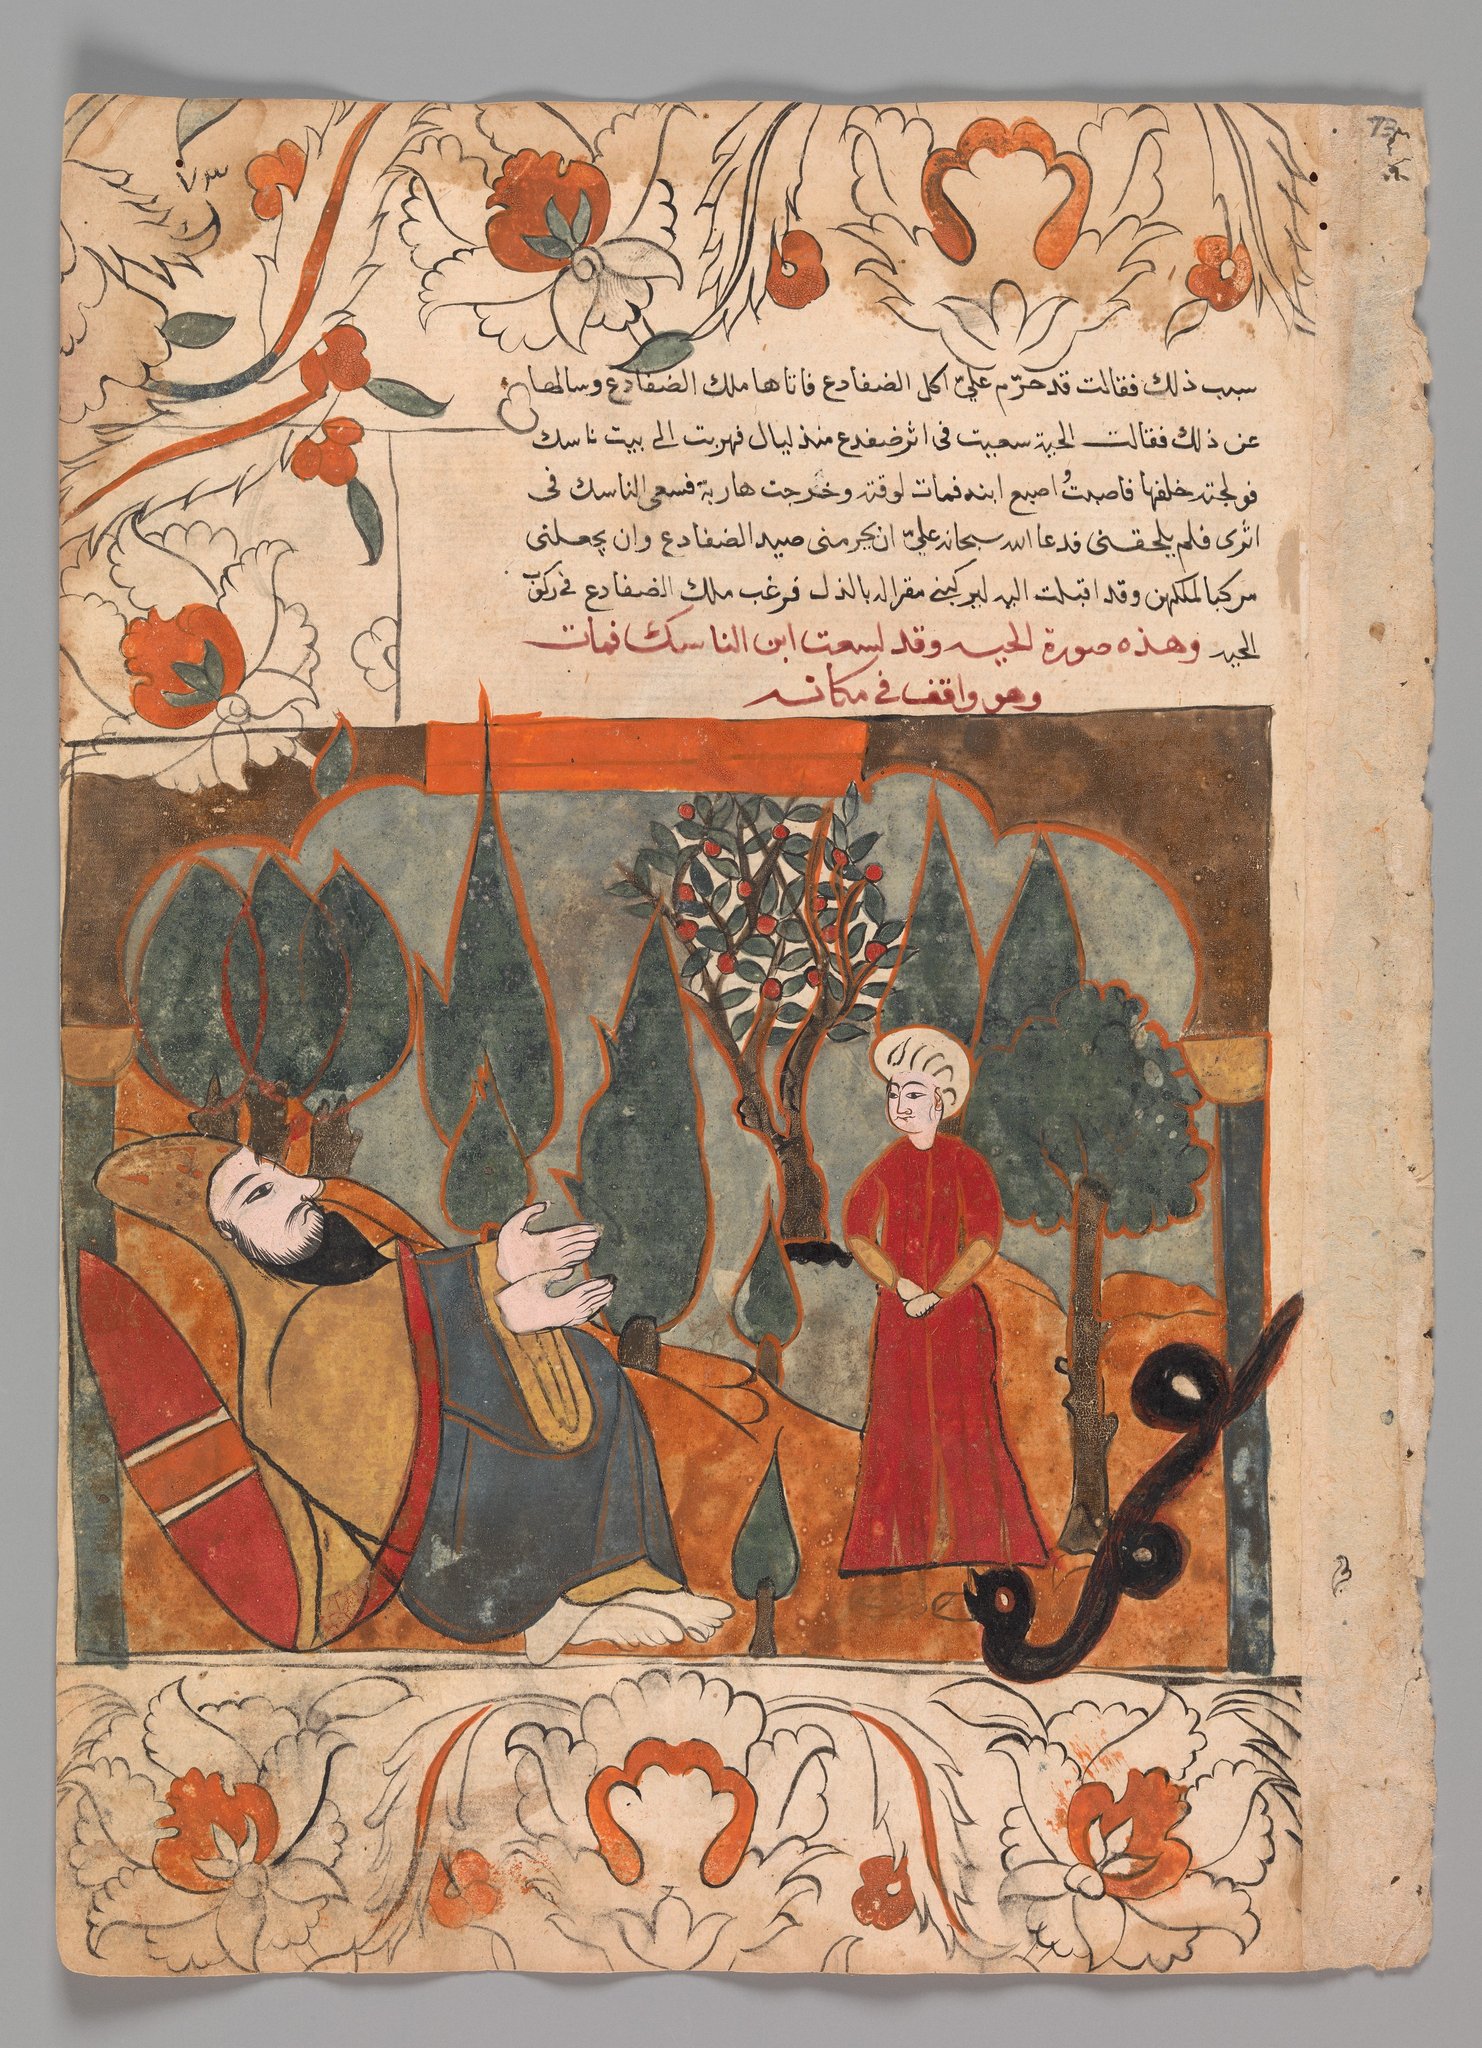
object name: folio from an illustrated manuscript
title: "The Old Snake Tells the Tale of Biting the Ascetic's Son by Mistake", Folio from a Kalila wa Dimna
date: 1526-1550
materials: ink, paper, watercolor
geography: india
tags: boys,men,snakes